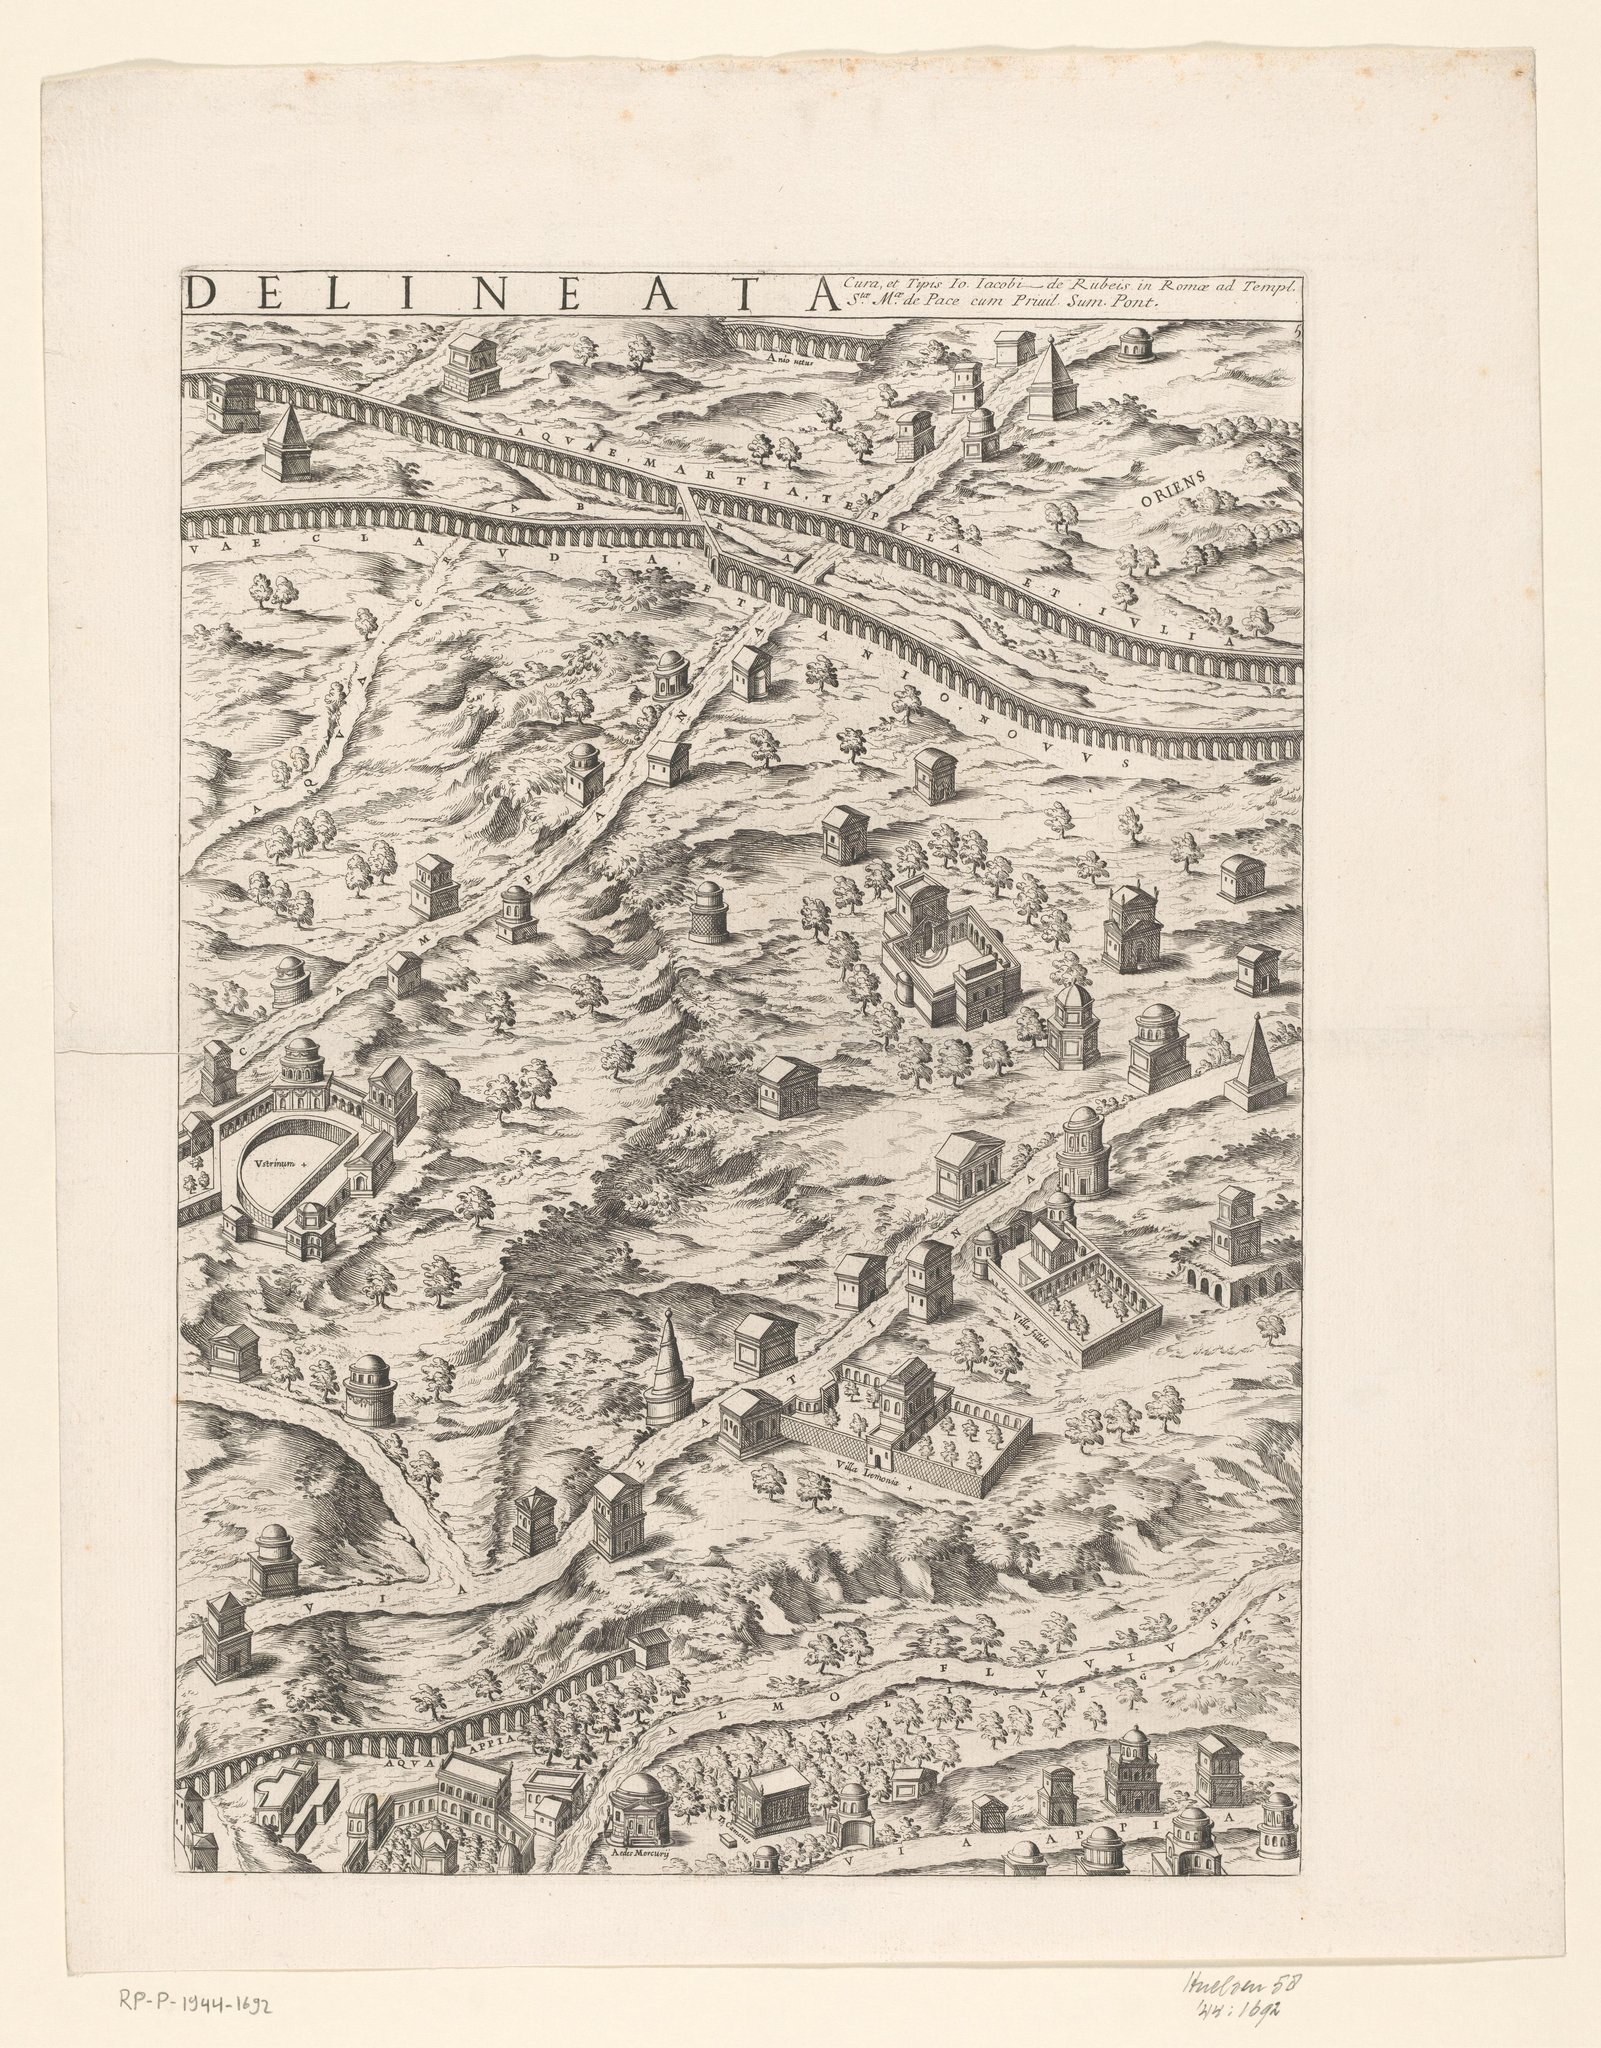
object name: print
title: Urbis Romae sciographia ex antiquis monumentis accuratiss delineata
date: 1639-1691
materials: paper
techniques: engraving, etching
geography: rome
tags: maps of cities, rome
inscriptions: collector's mark: Lugt 2228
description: Vierde deel van een plattegrond van Rome in vogelvluchtperspectief, bestaande uit acht delen. Rechtsboven genummerd: 5.